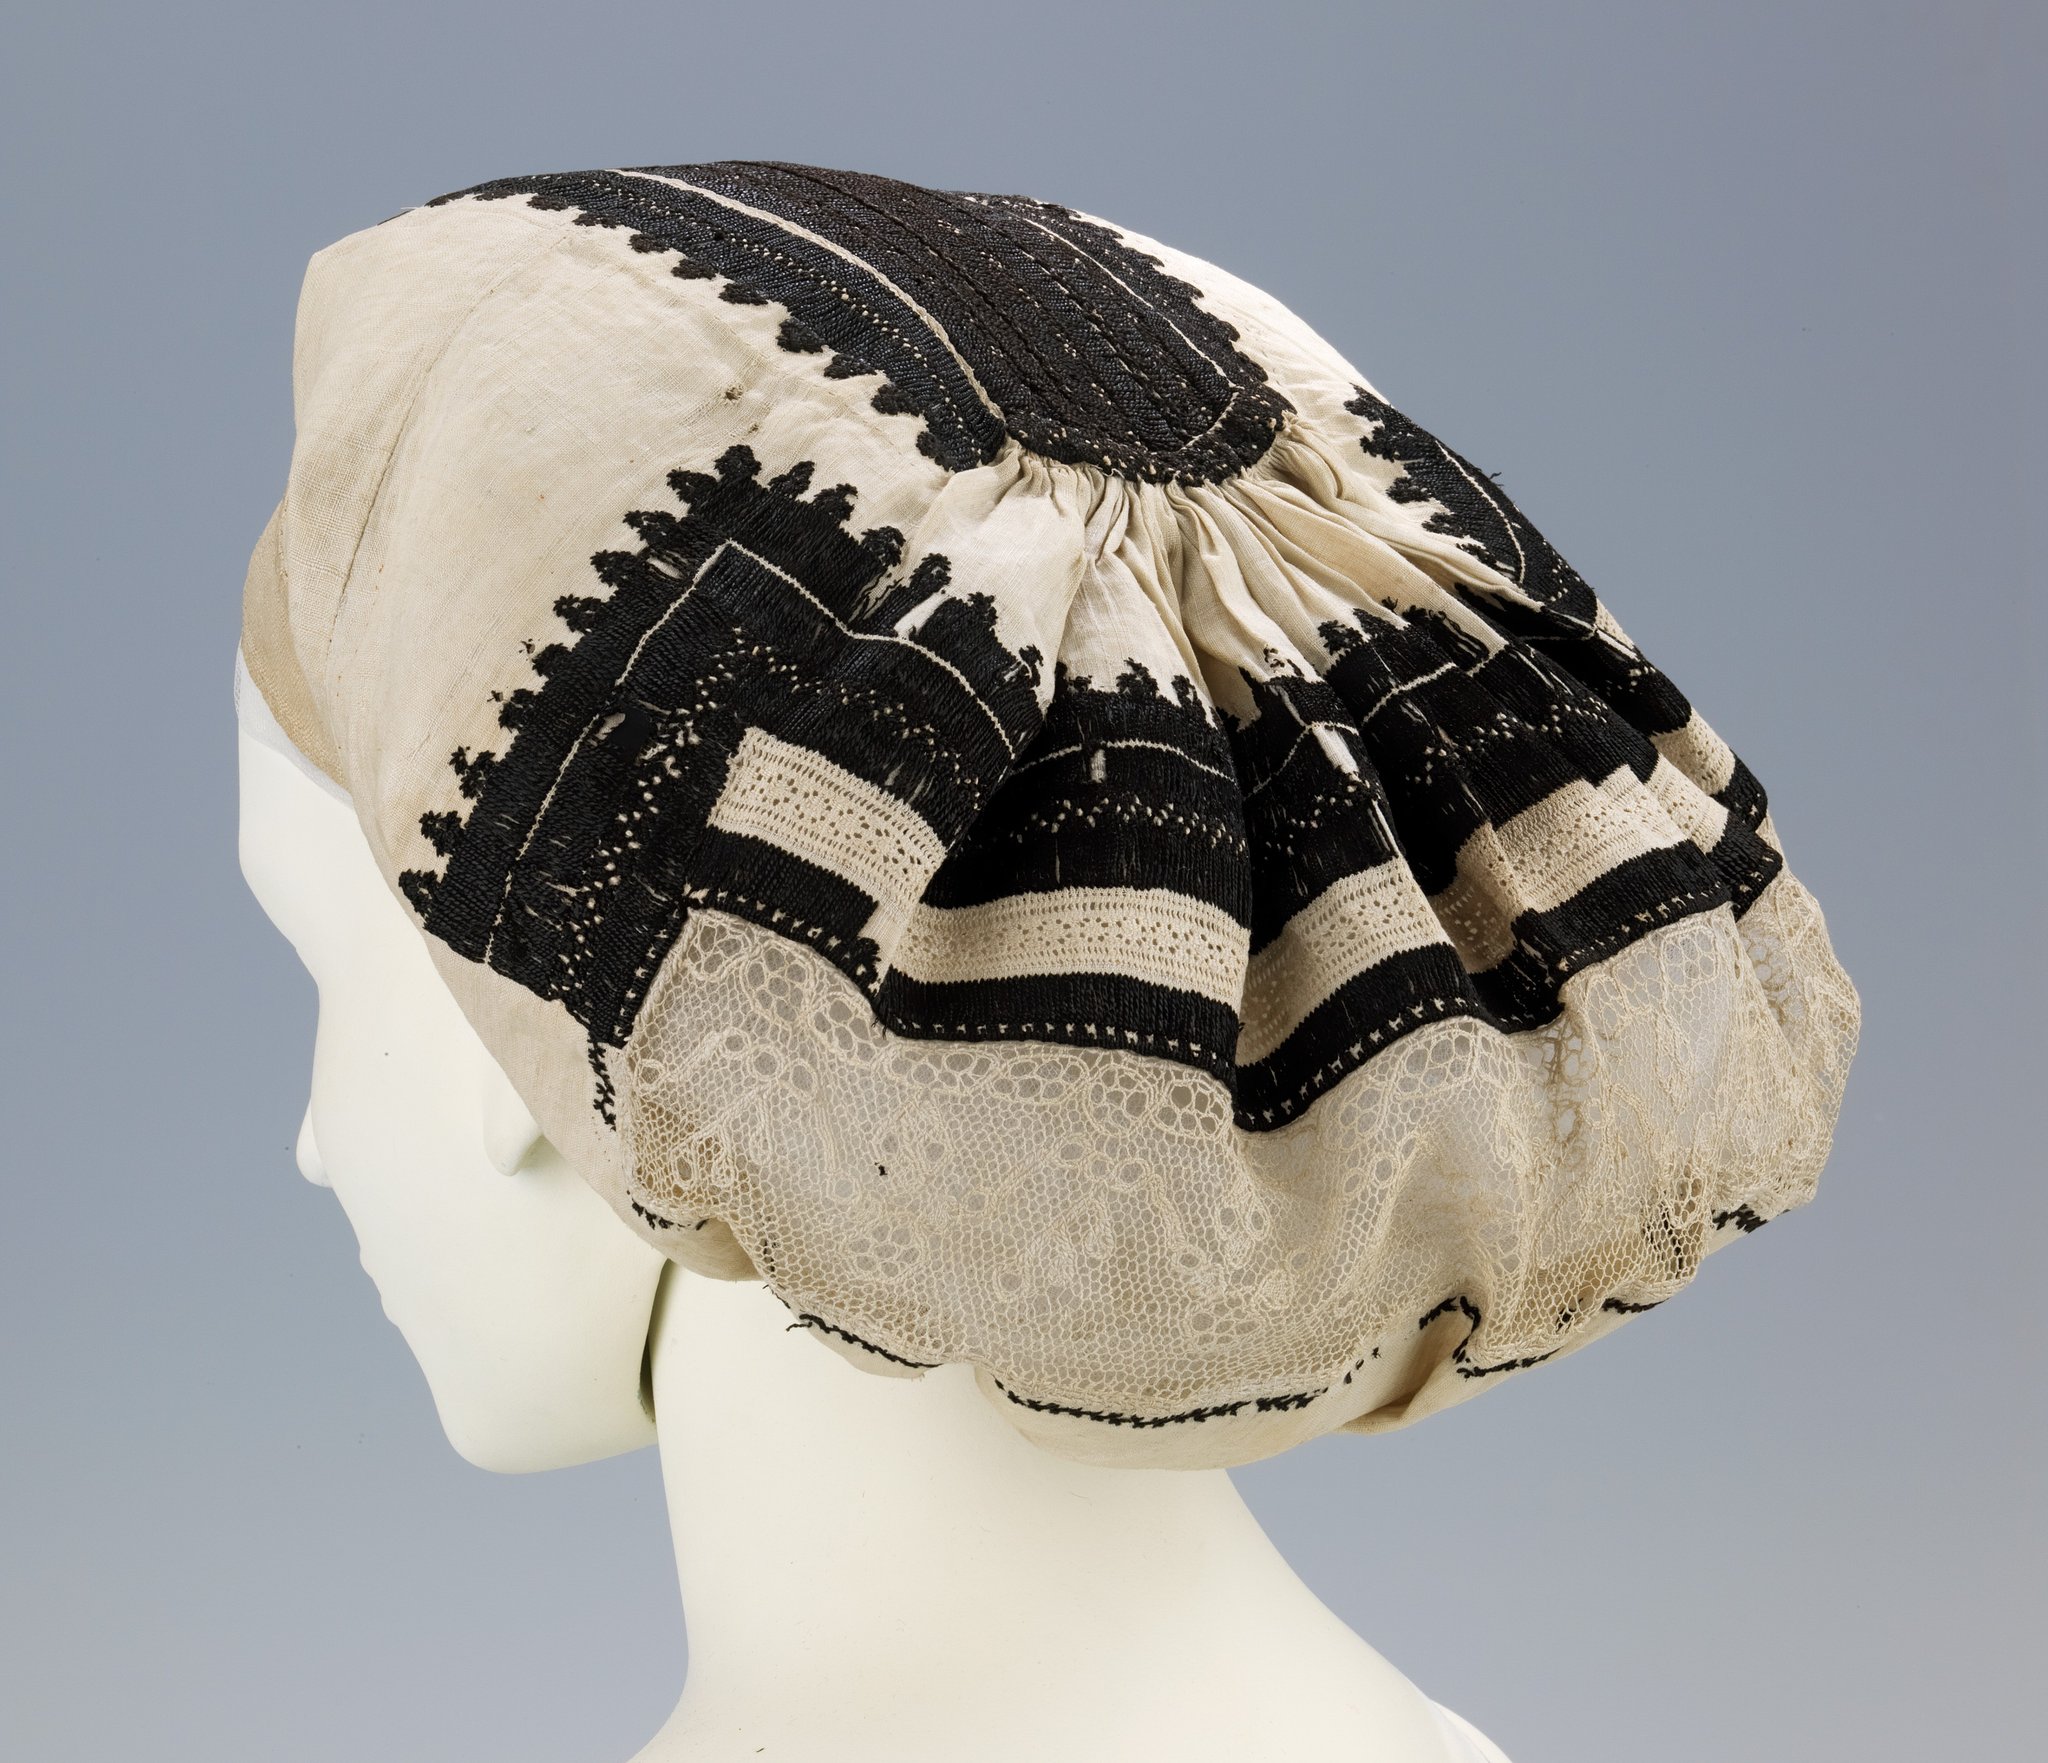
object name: cap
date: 1840-1860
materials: linen, silk